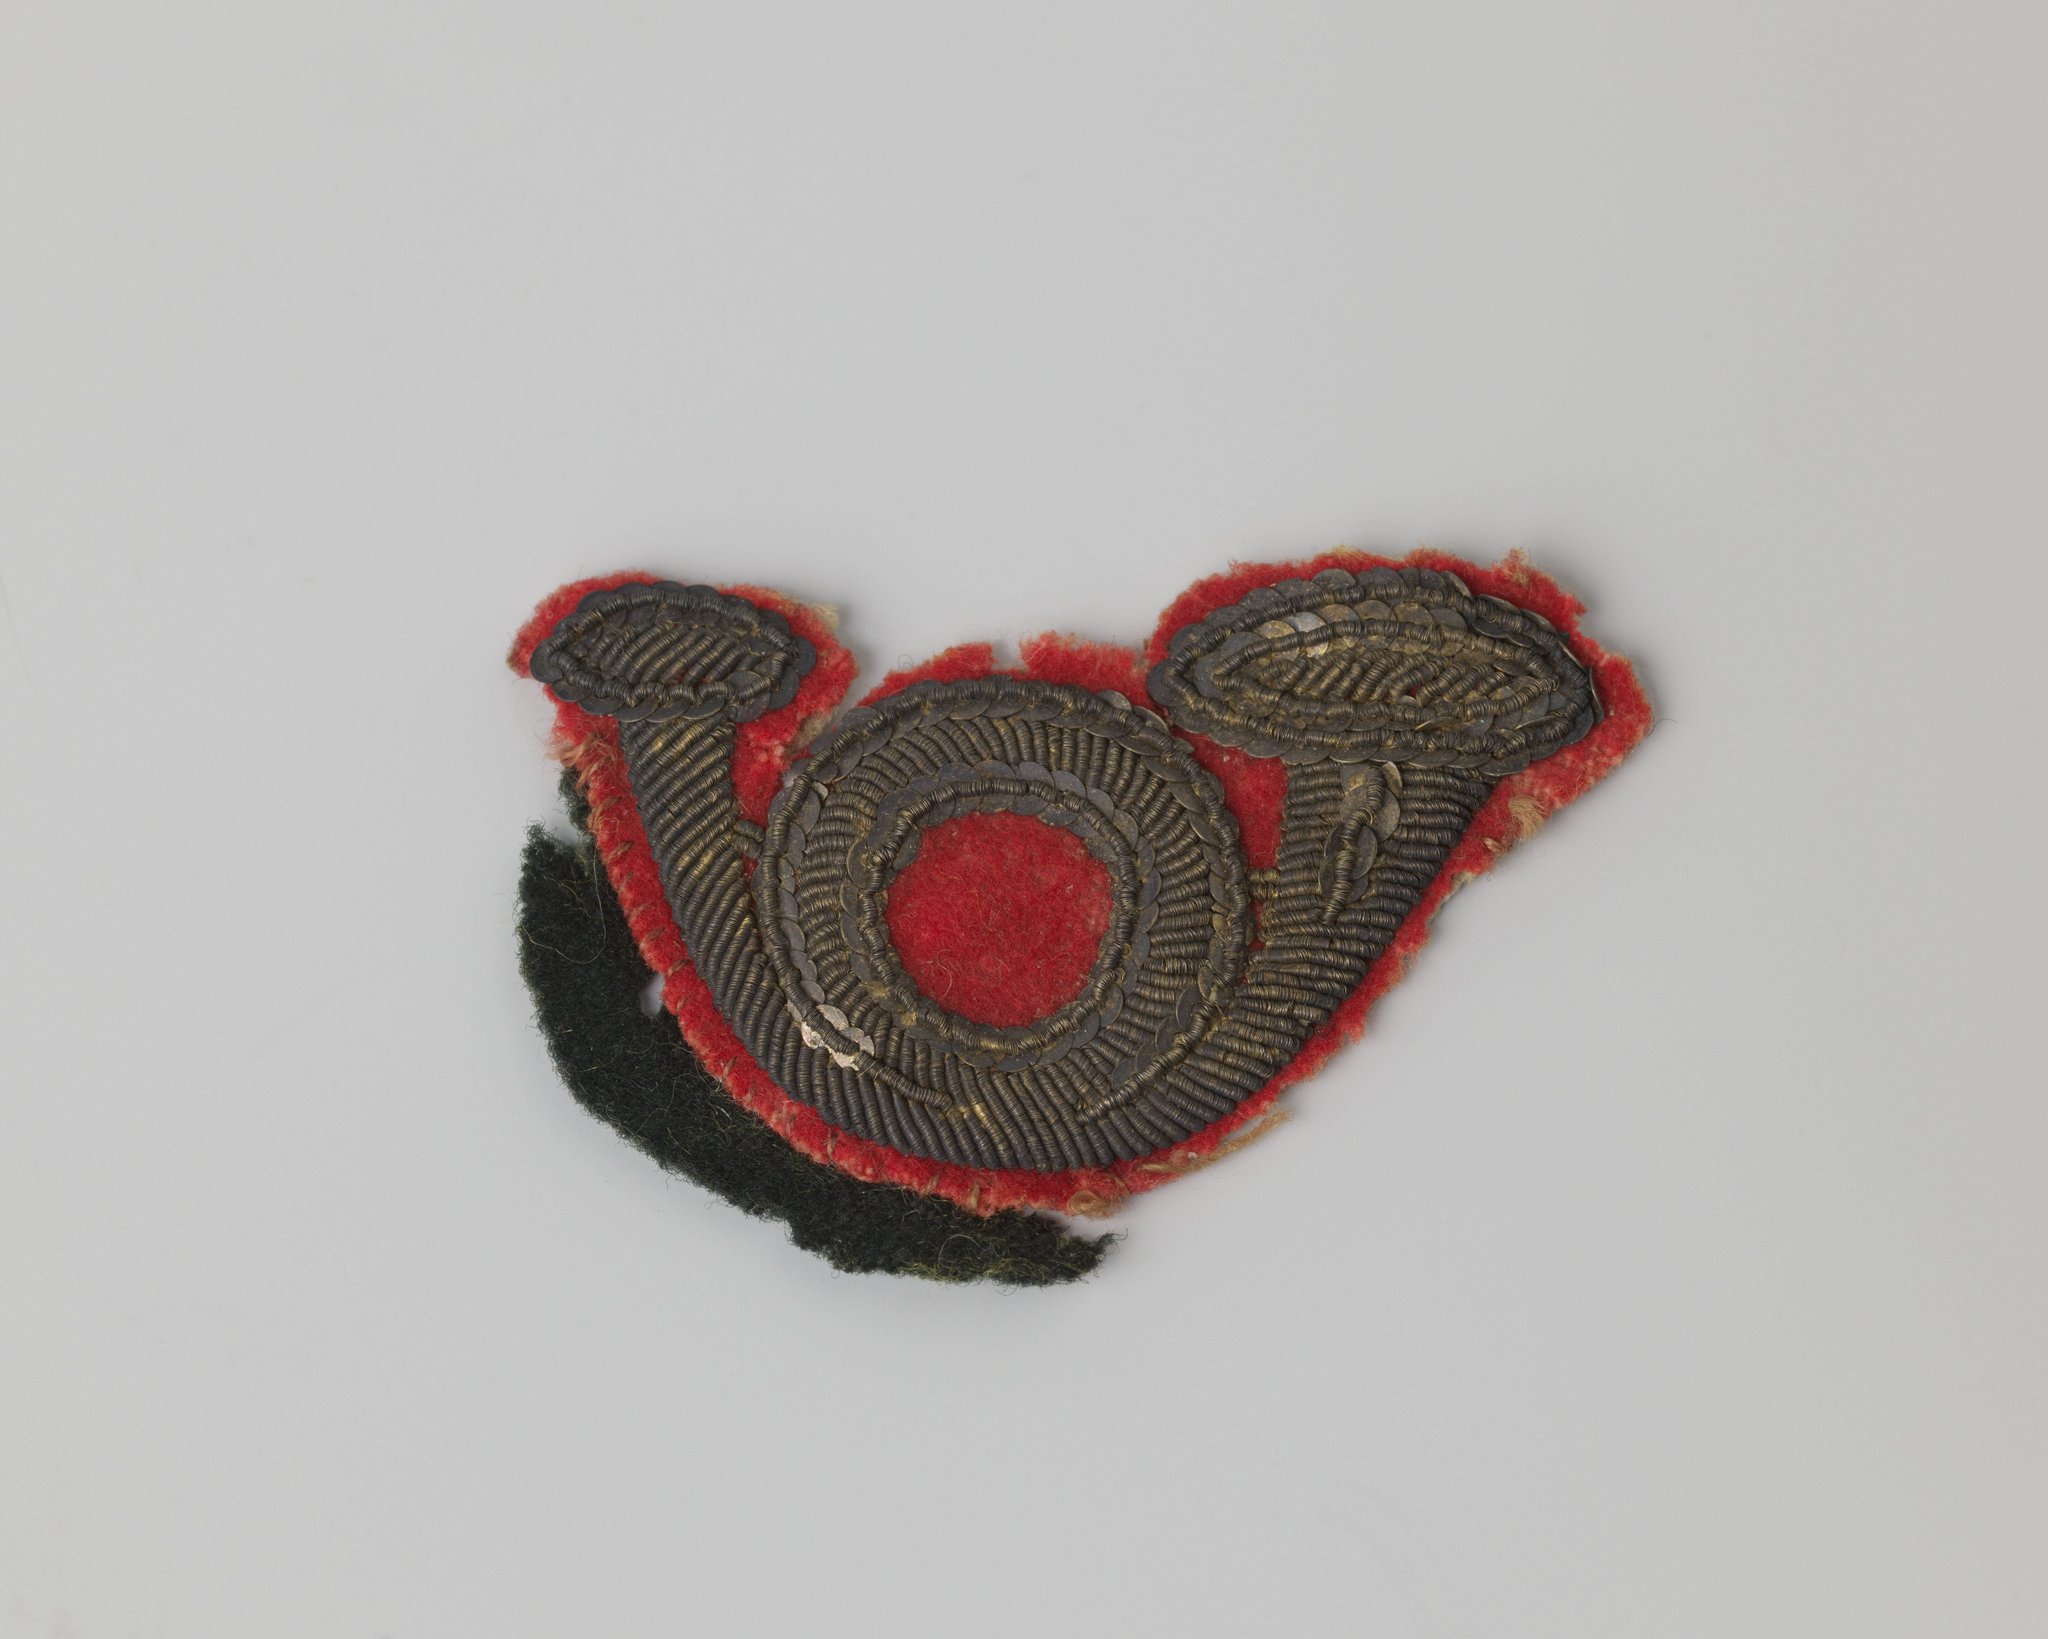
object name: insignia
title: Militair distinctief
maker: Anonymous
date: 1830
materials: cardboard, textile, linen, thread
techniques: embroidered, stitching, weave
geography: netherlands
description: Insigne in de vorm van een posthoorn, in zilverdraad geborduurd op rood laken. Achter linnen en karton. Linksonder hangt nog een stukje zwart laken.